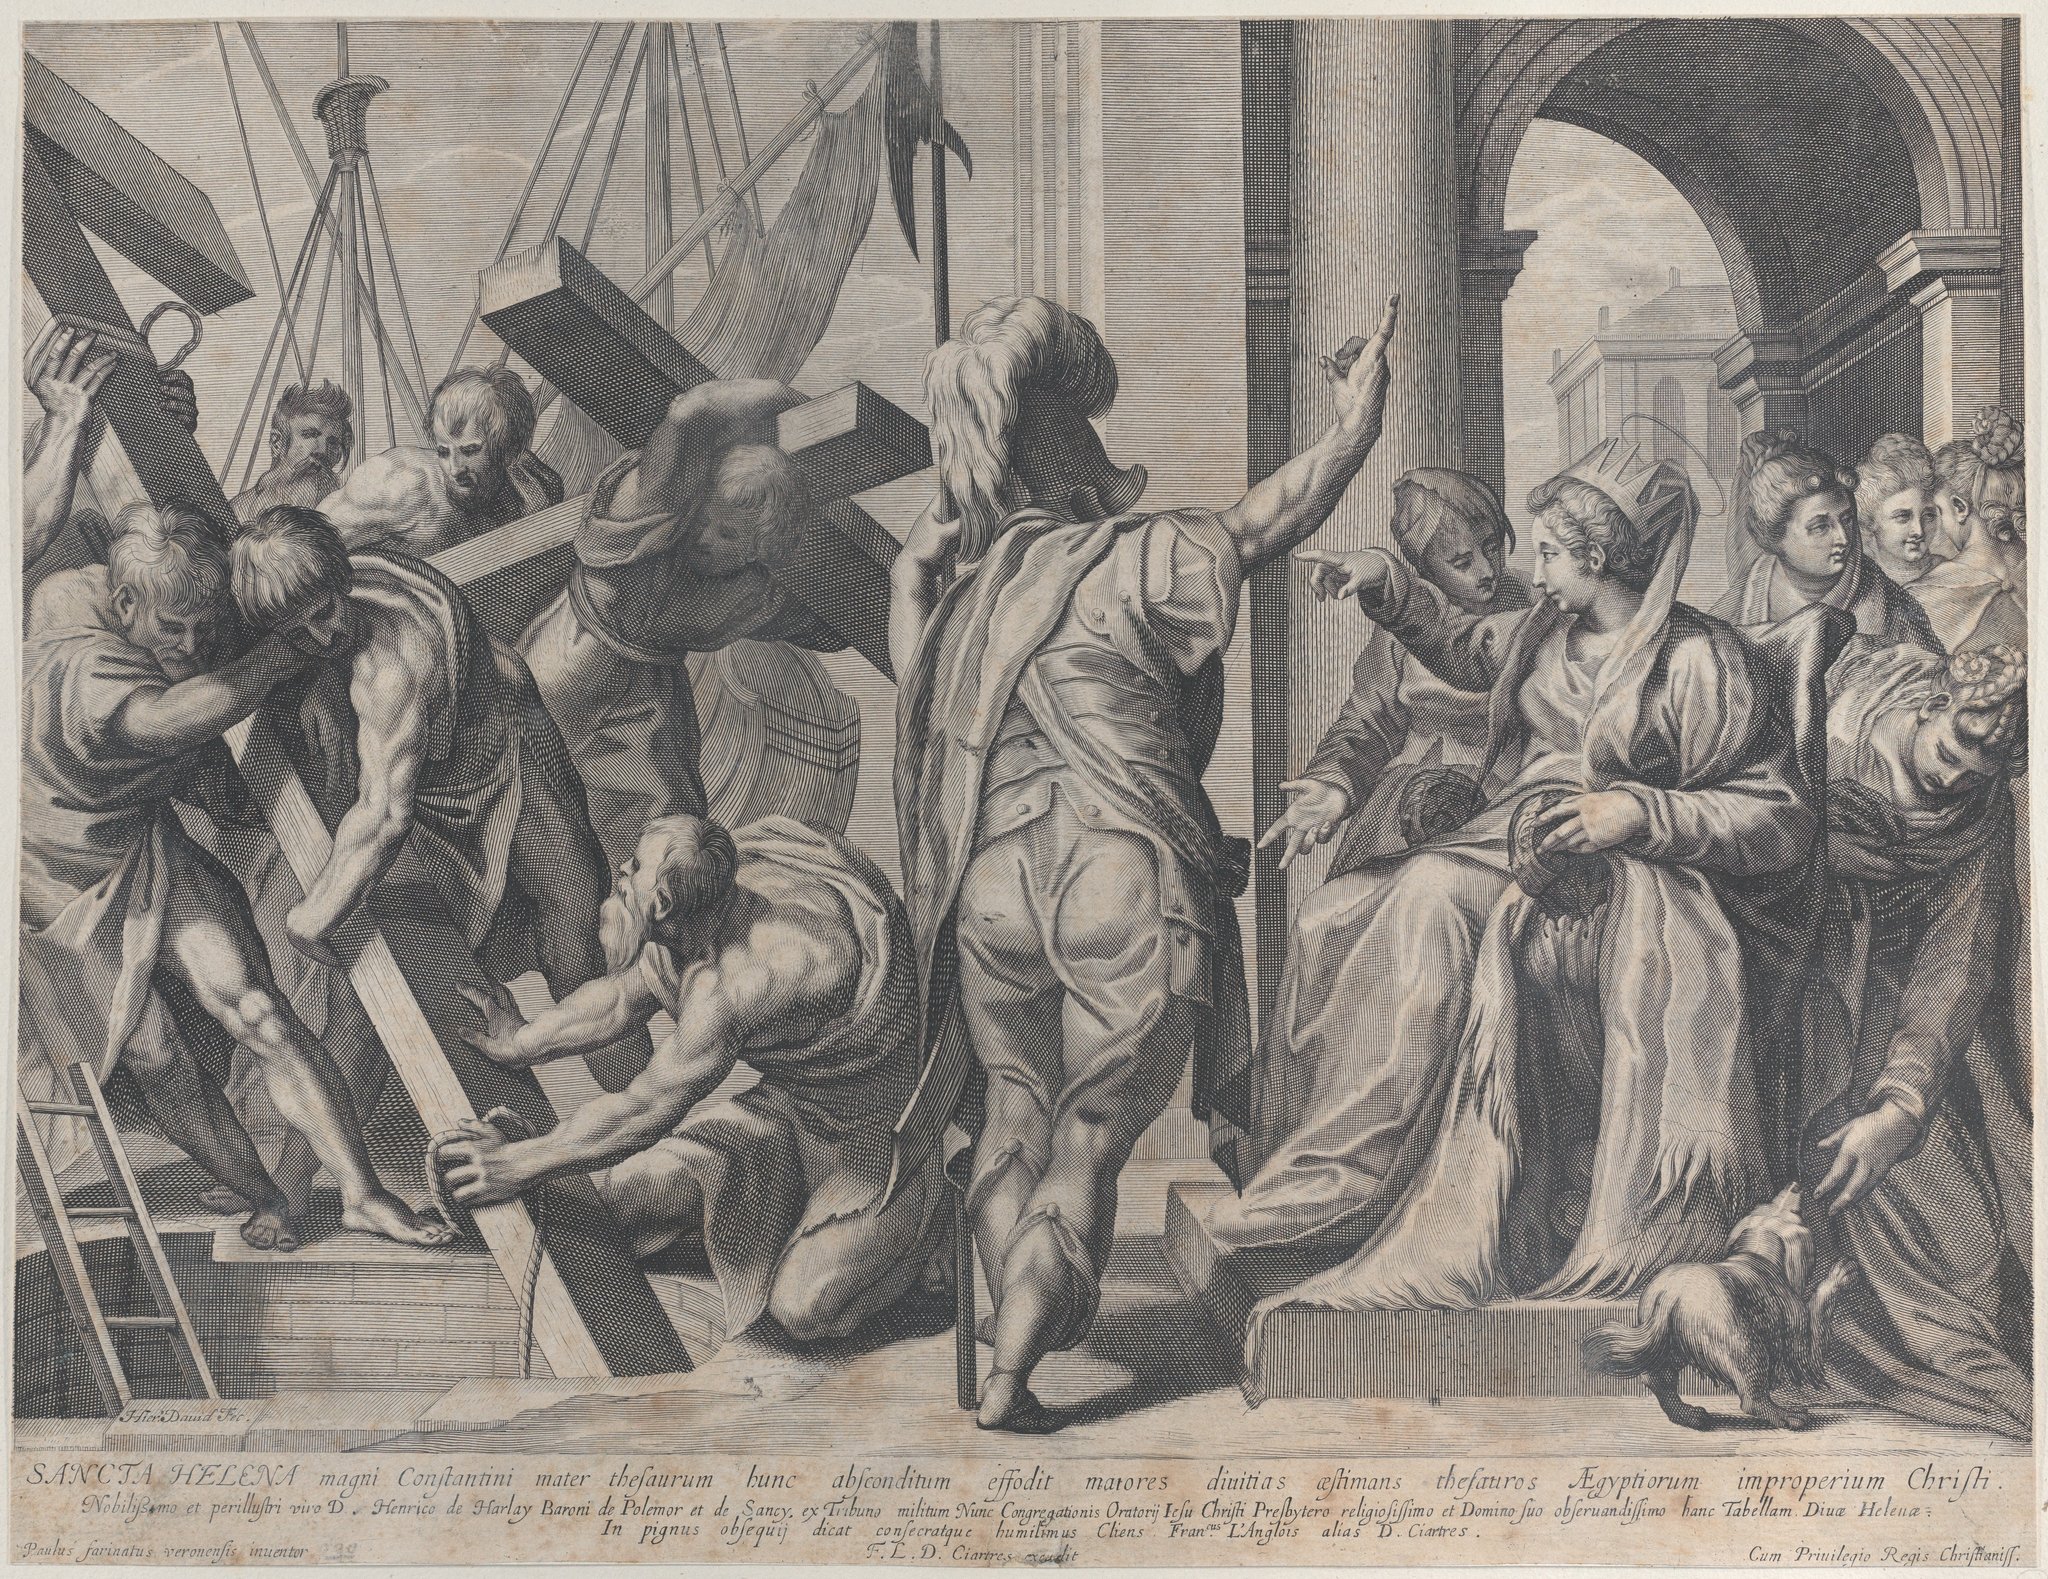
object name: print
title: Saint Helen finding the true cross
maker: jerôme david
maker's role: artist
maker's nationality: french?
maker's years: 1605-1670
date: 1625-1647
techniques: engraving